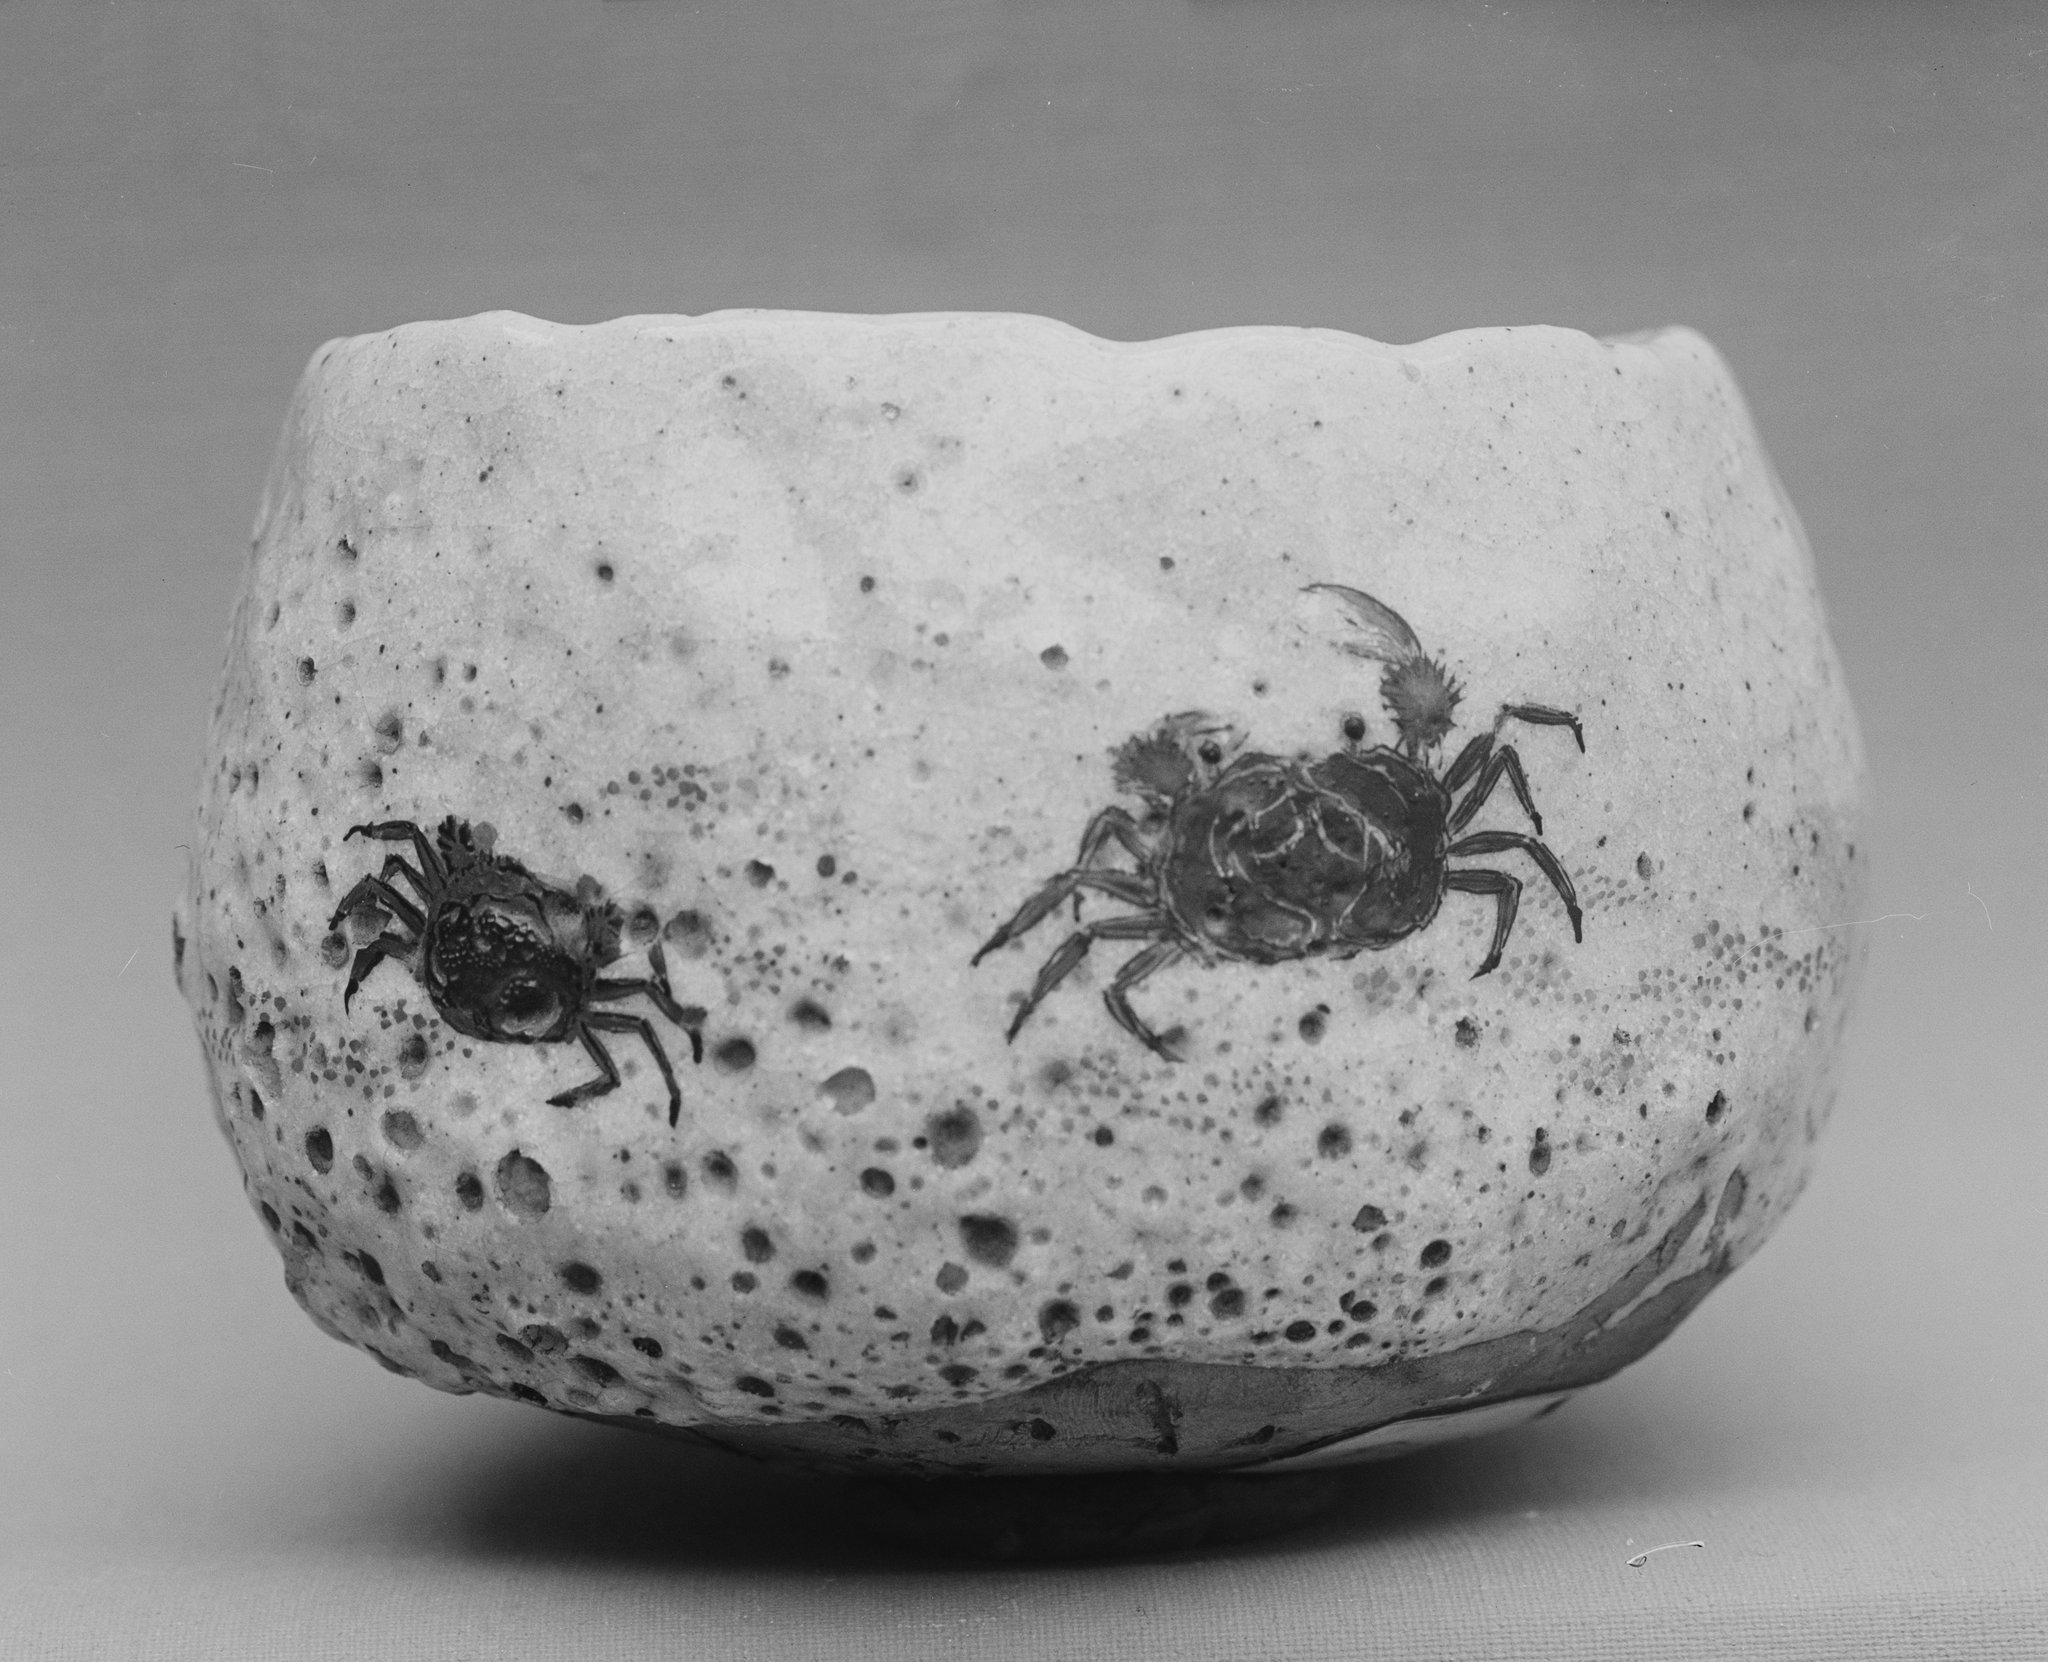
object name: teabowl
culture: japanese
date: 1800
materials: clay, glaze, gold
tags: crabs